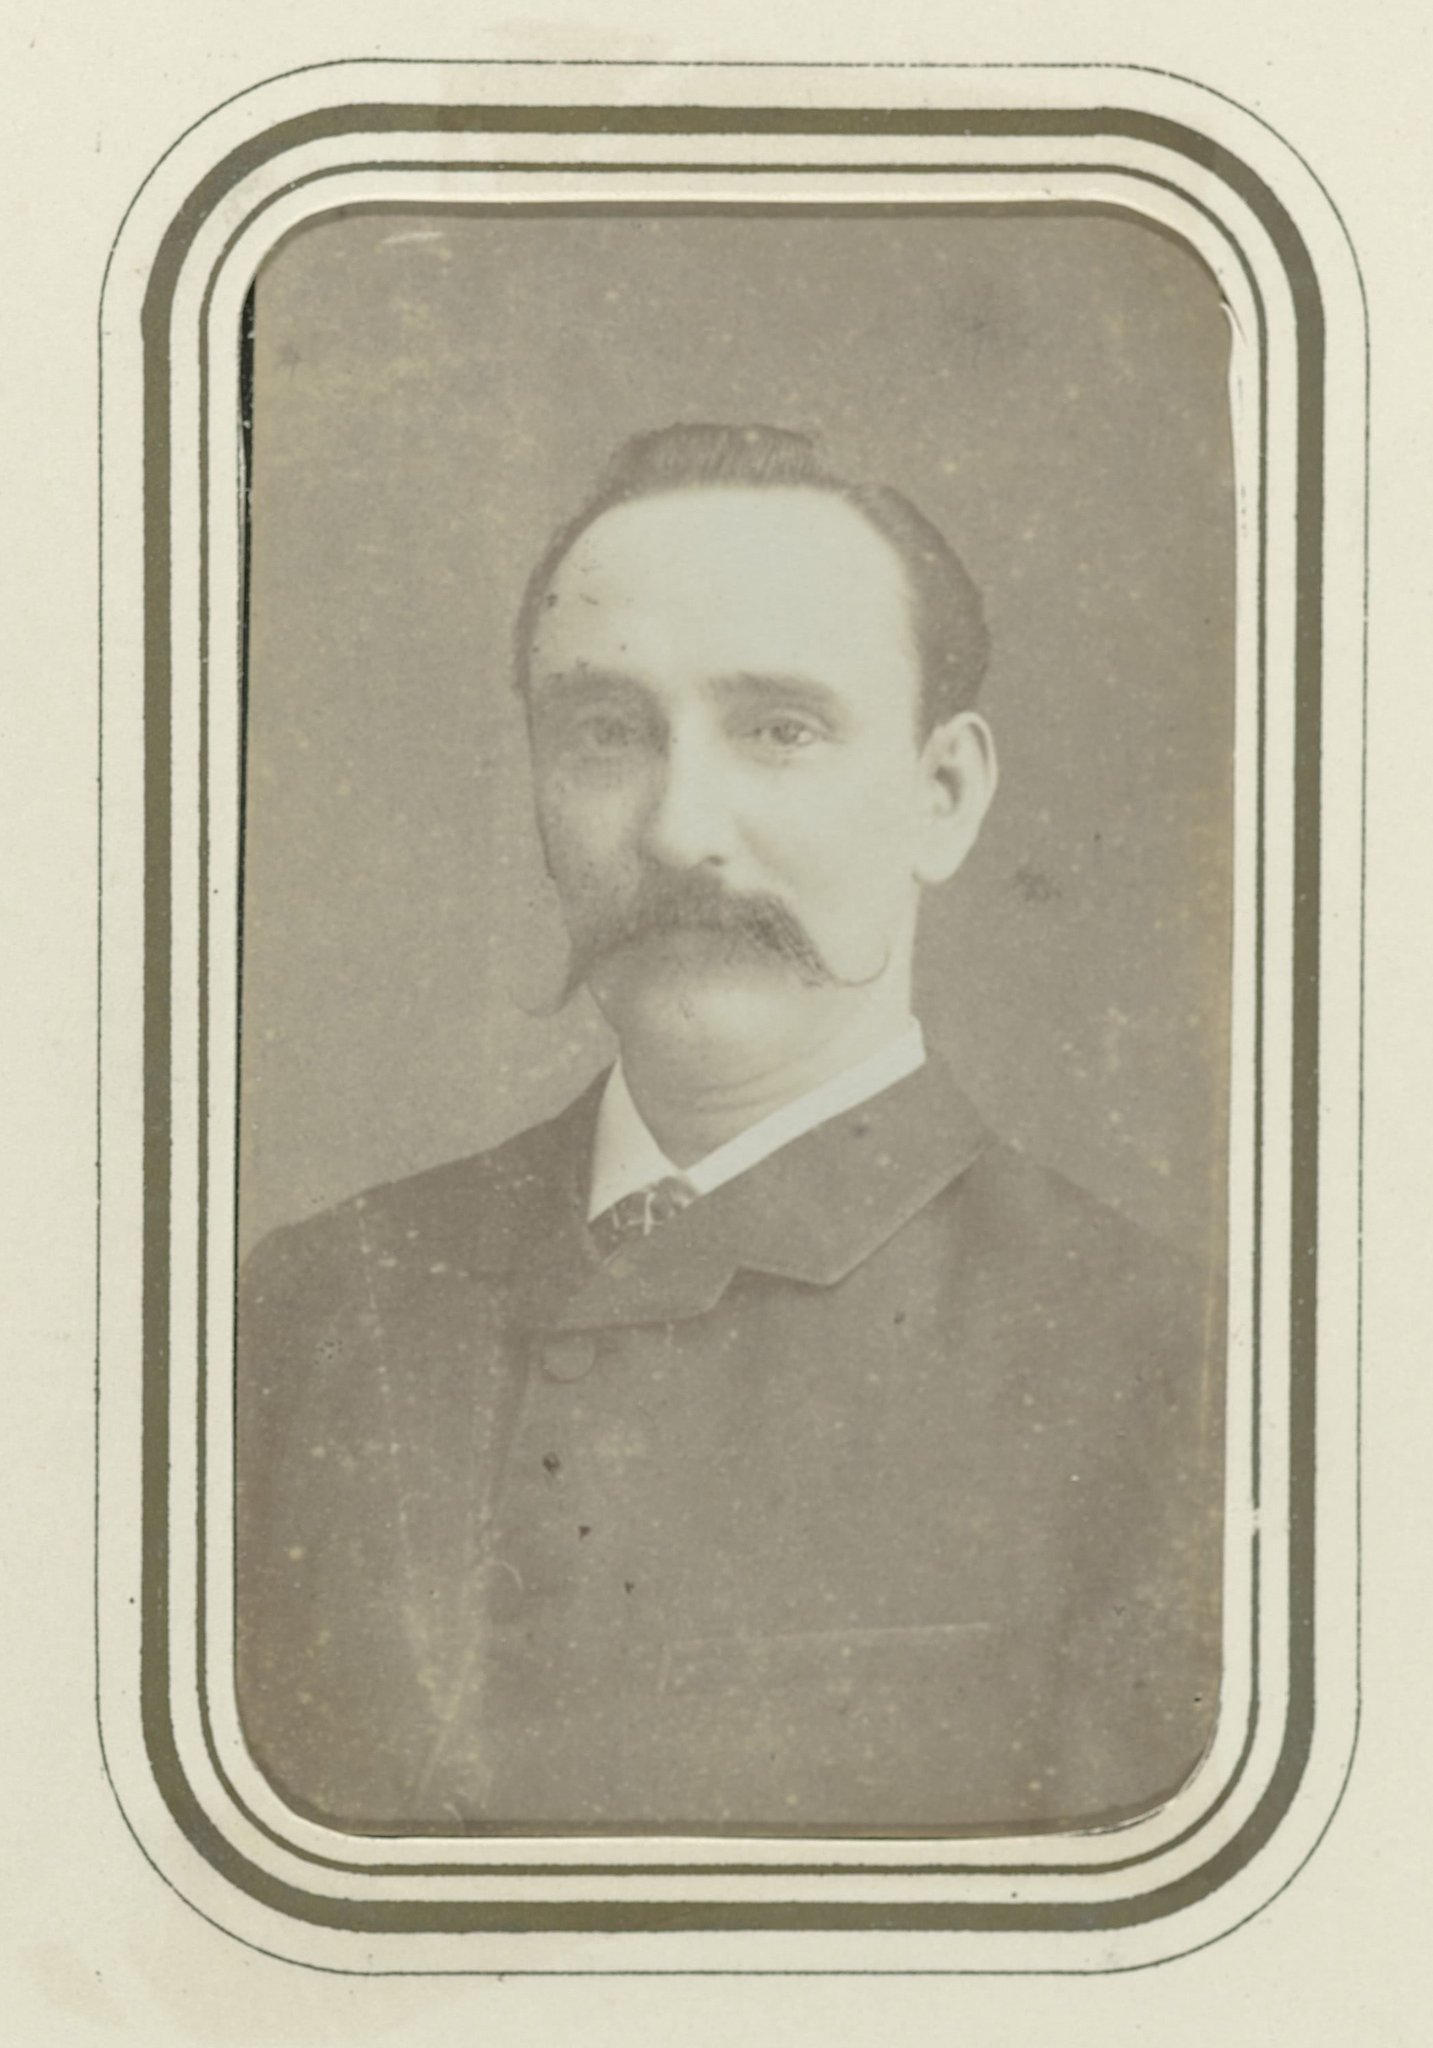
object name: photograph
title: Mansportret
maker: Anonymous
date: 1880-1886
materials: photographic support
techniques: photography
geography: dutch east indies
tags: anonymous historical person portrayed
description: Carte-de-visite met het portret van een onbekende man. Waarschijnlijk één van de aanbieders van het fotoalbum. Ingestoken in het fotoalbum aangeboden aan J.M. Pijnacker Hordijk bij zijn vertrek uit Jogyakarta in 1886.